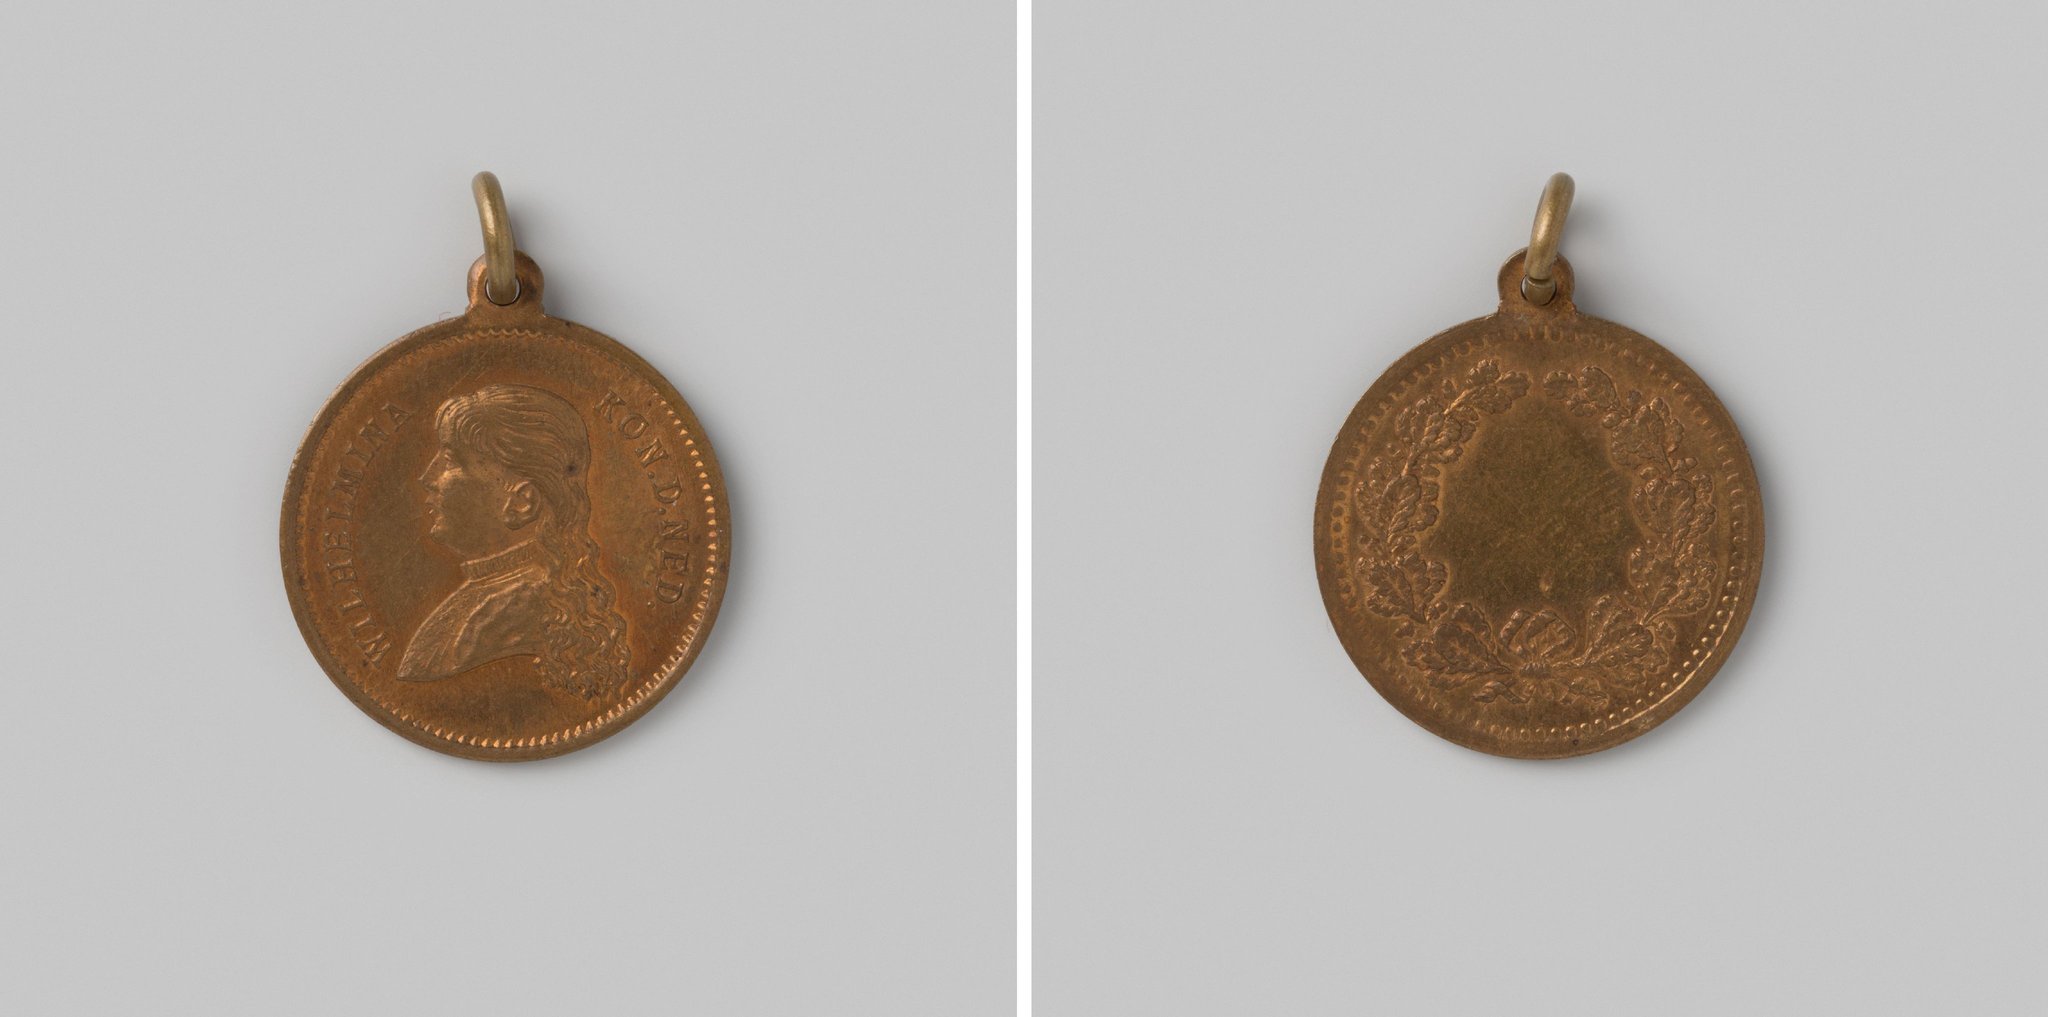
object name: history medal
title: Wilhelmina Koningin der Nederlanden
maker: wolfgang lauer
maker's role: medailleur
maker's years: 1856-1915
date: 1890-1898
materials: brass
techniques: striking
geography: nuremberg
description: Goudkleurige messing penning met oog en draagring, op de voorzijde het borstbeeld van Wilhelmina met hangend haar naar links met omschrift, op de keerzijde een leeg veld tussen twee samengestrikte eikentakken.